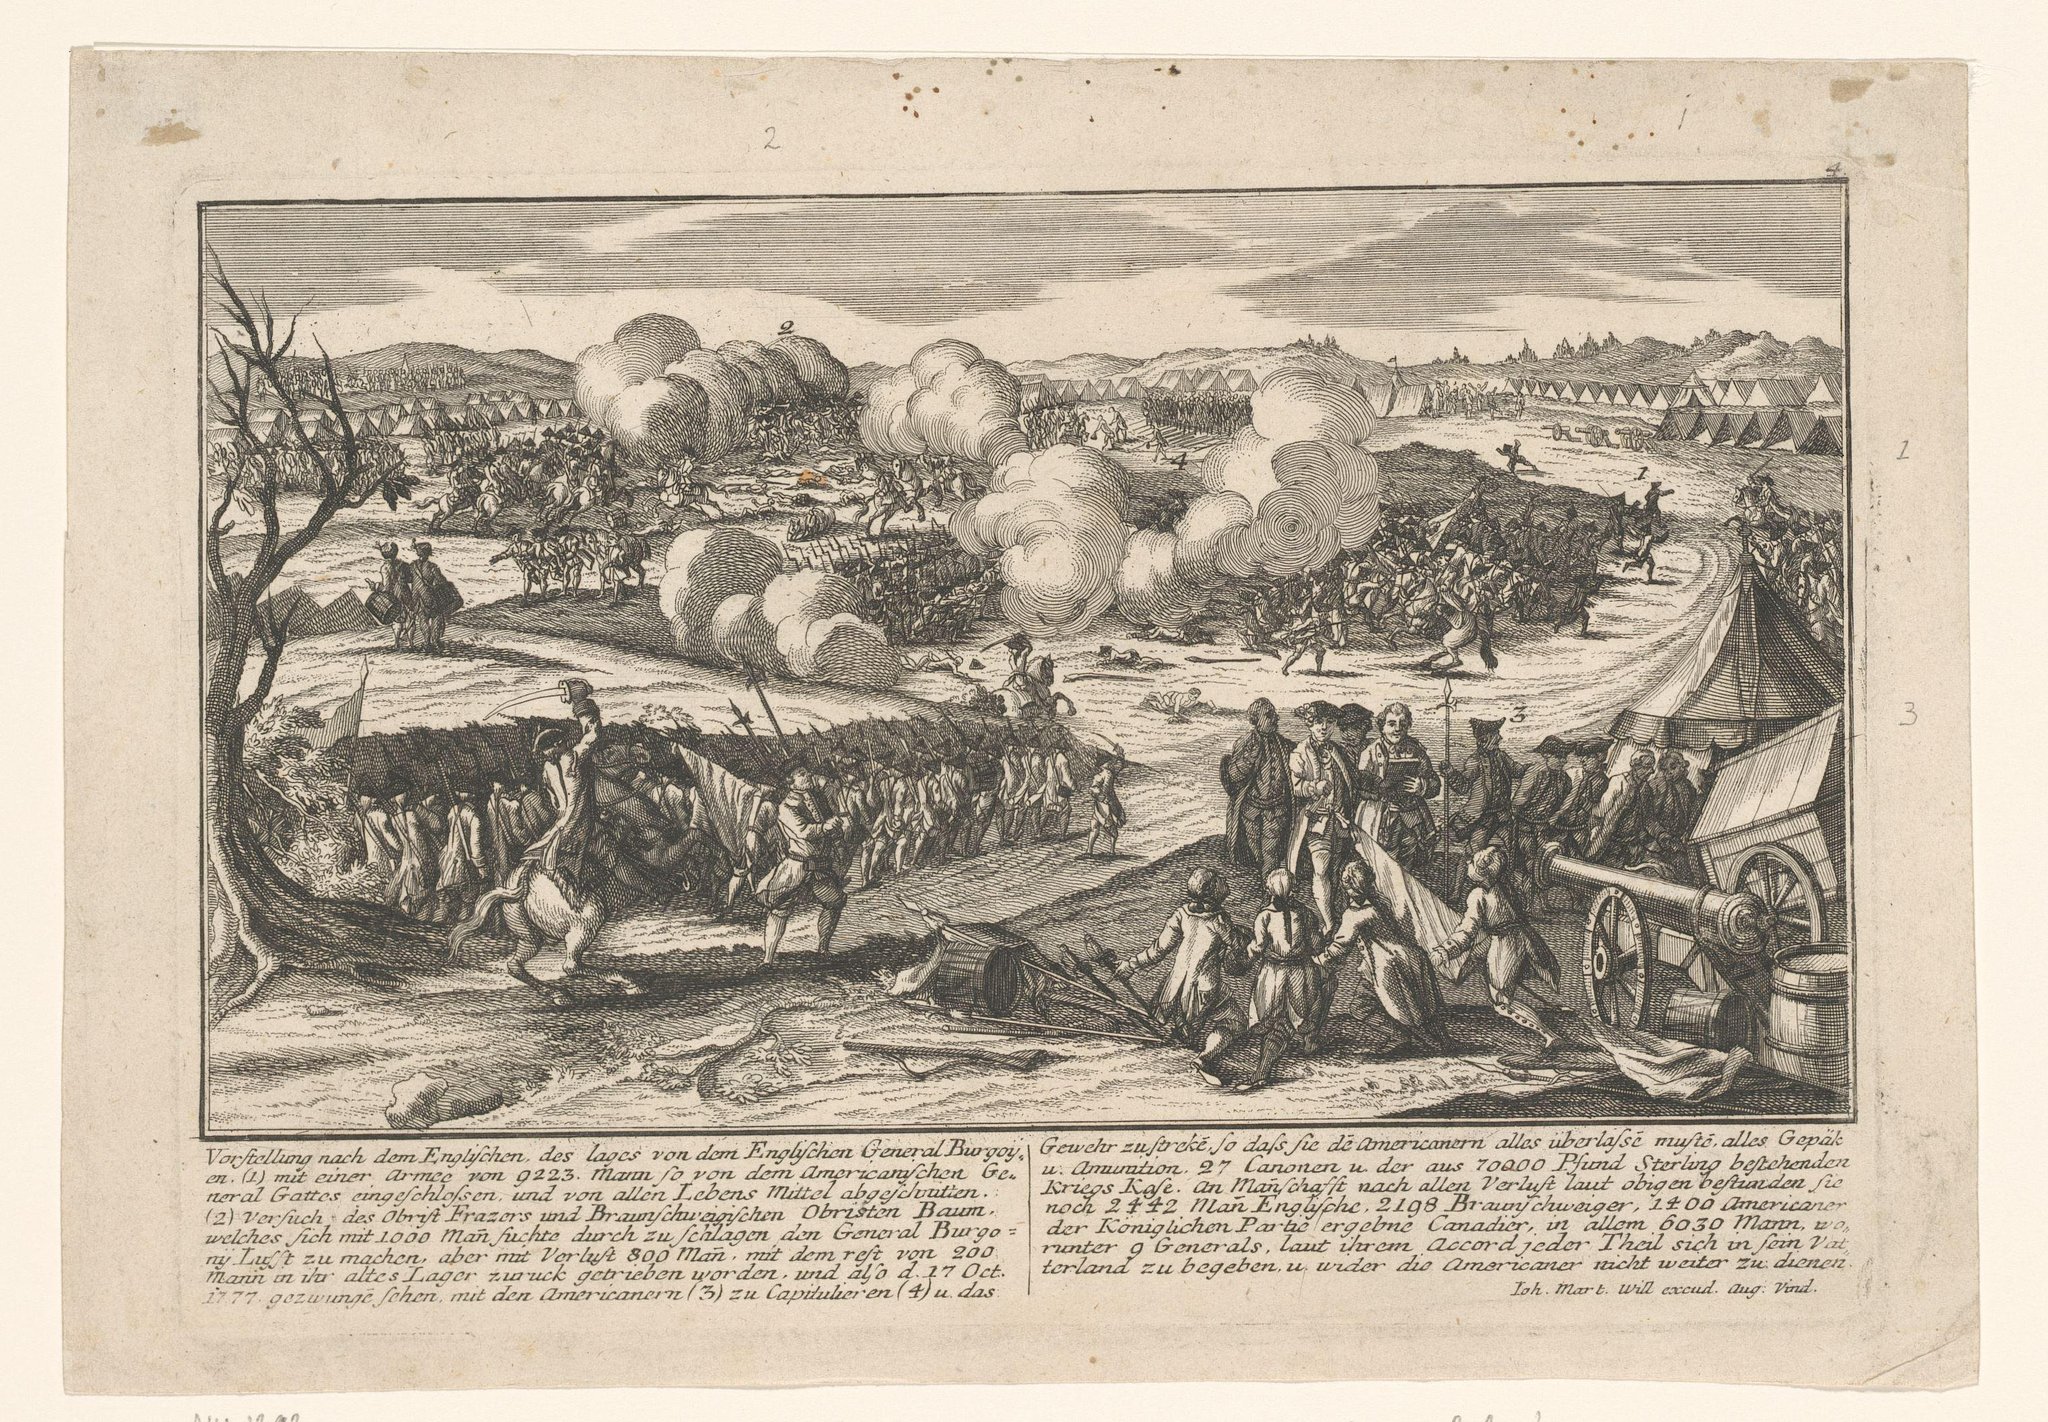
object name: print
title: Overgave van Generaal Burgoyne aan Generaal Gates op 17 oktober 1777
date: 1777-1806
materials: paper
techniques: engraving, etching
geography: augsburg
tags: surrender ~ war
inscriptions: collector's mark: Lugt 2228, caption: ‘Vostellung nach dem Englischen des Lages von dem Englischem General Burgoy/en...die Americaner nicht weiter zu dienen.’, address: ‘Ioh. Mart. Will excud. Aug. Vind.’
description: De Engelse Generaal Burgoyne wordt op 17 oktober 1777 bij Saratoga door de Amerikaanse generaal Gates gedwongen de wapens neer te leggen. Met legenda in onderschrift in twee kolommen in het Duits. Rechtsboven genummerd 4.